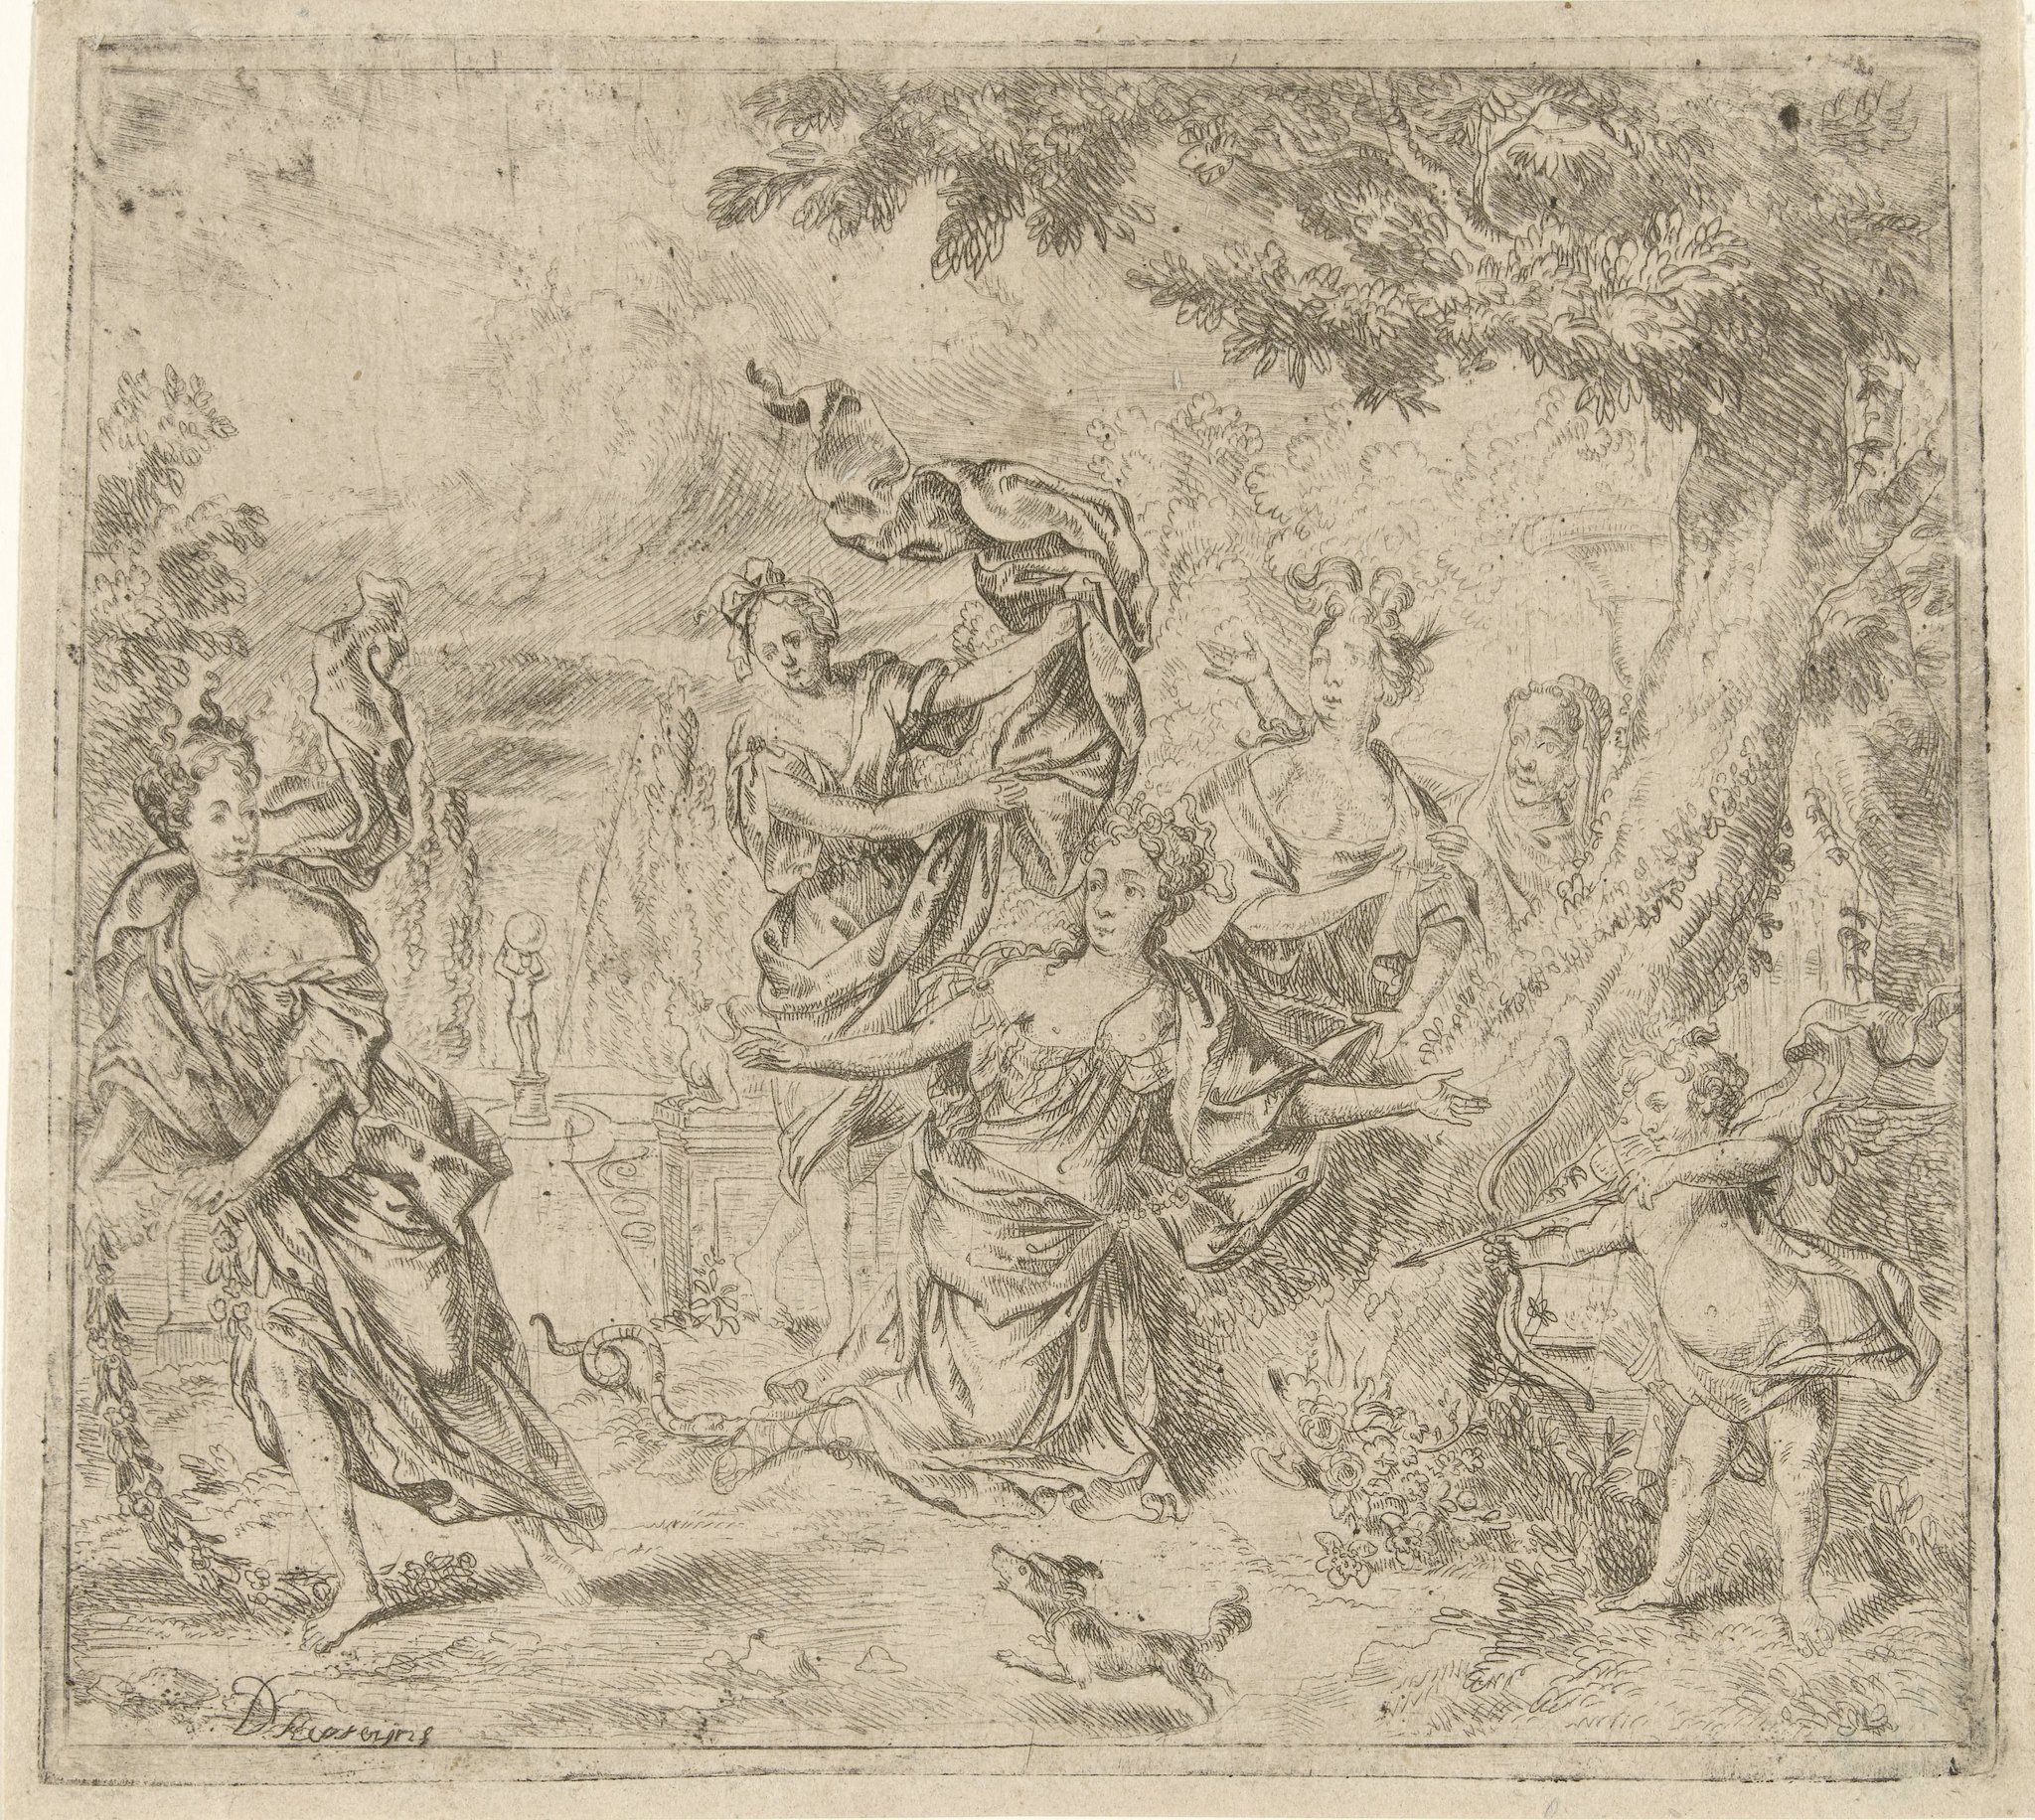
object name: print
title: Eurydice gedood door een slang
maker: daniël herreyns (i)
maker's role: print maker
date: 1600-1649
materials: paper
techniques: etching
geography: antwerp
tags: eurydice, while fleeing from aristaeus, is killed by a snake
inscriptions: collector's mark: Lugt 2165, collector's mark: Lugt 2228, inscription: ‘La mort d'Eurydice.’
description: Eurydice, in het gezelschap van vier vrouwen en Amor met pijl en boog, wordt in haar voet gebeten door een slang.